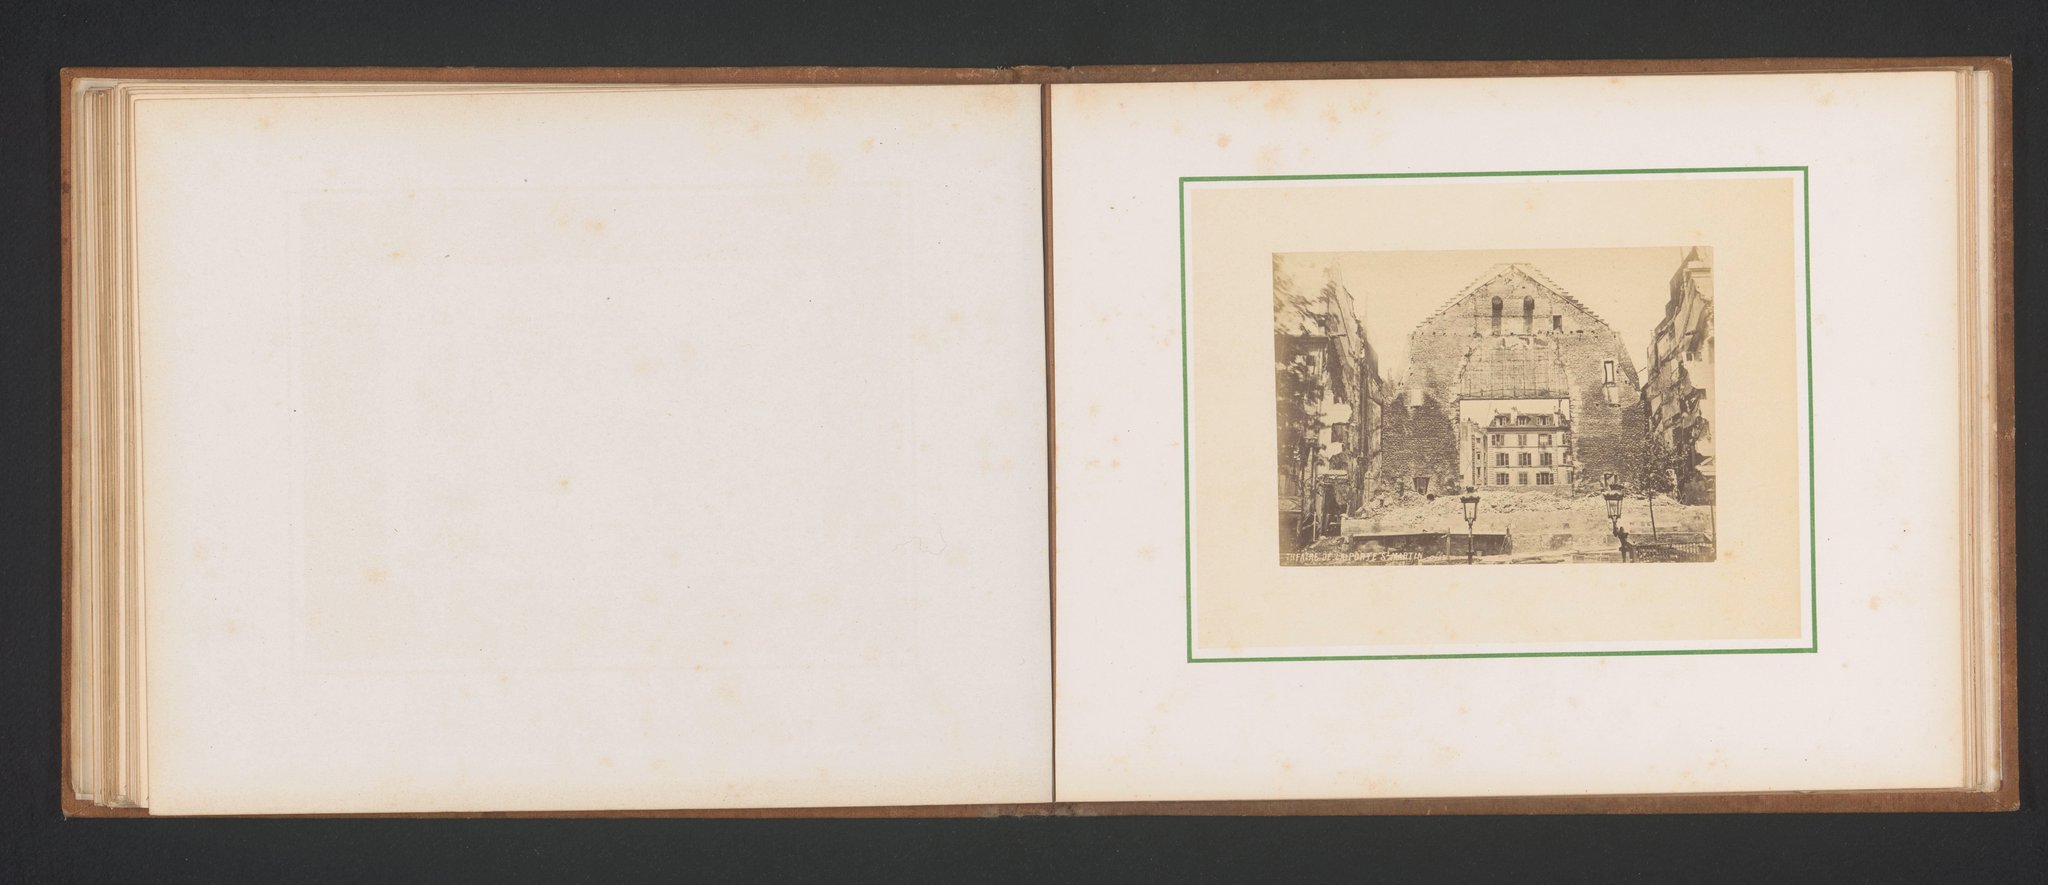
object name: photograph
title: Gezicht op het Théâtre de la Porte Saint-Martin in Parijs na de brand door de Commune van Parijs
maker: p. loubère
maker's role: fotograaf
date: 1871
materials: photographic support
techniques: albumen print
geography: paris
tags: ruin of a building ~ architecture, theatre (building)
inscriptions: monogram: ‘P.[L.]’